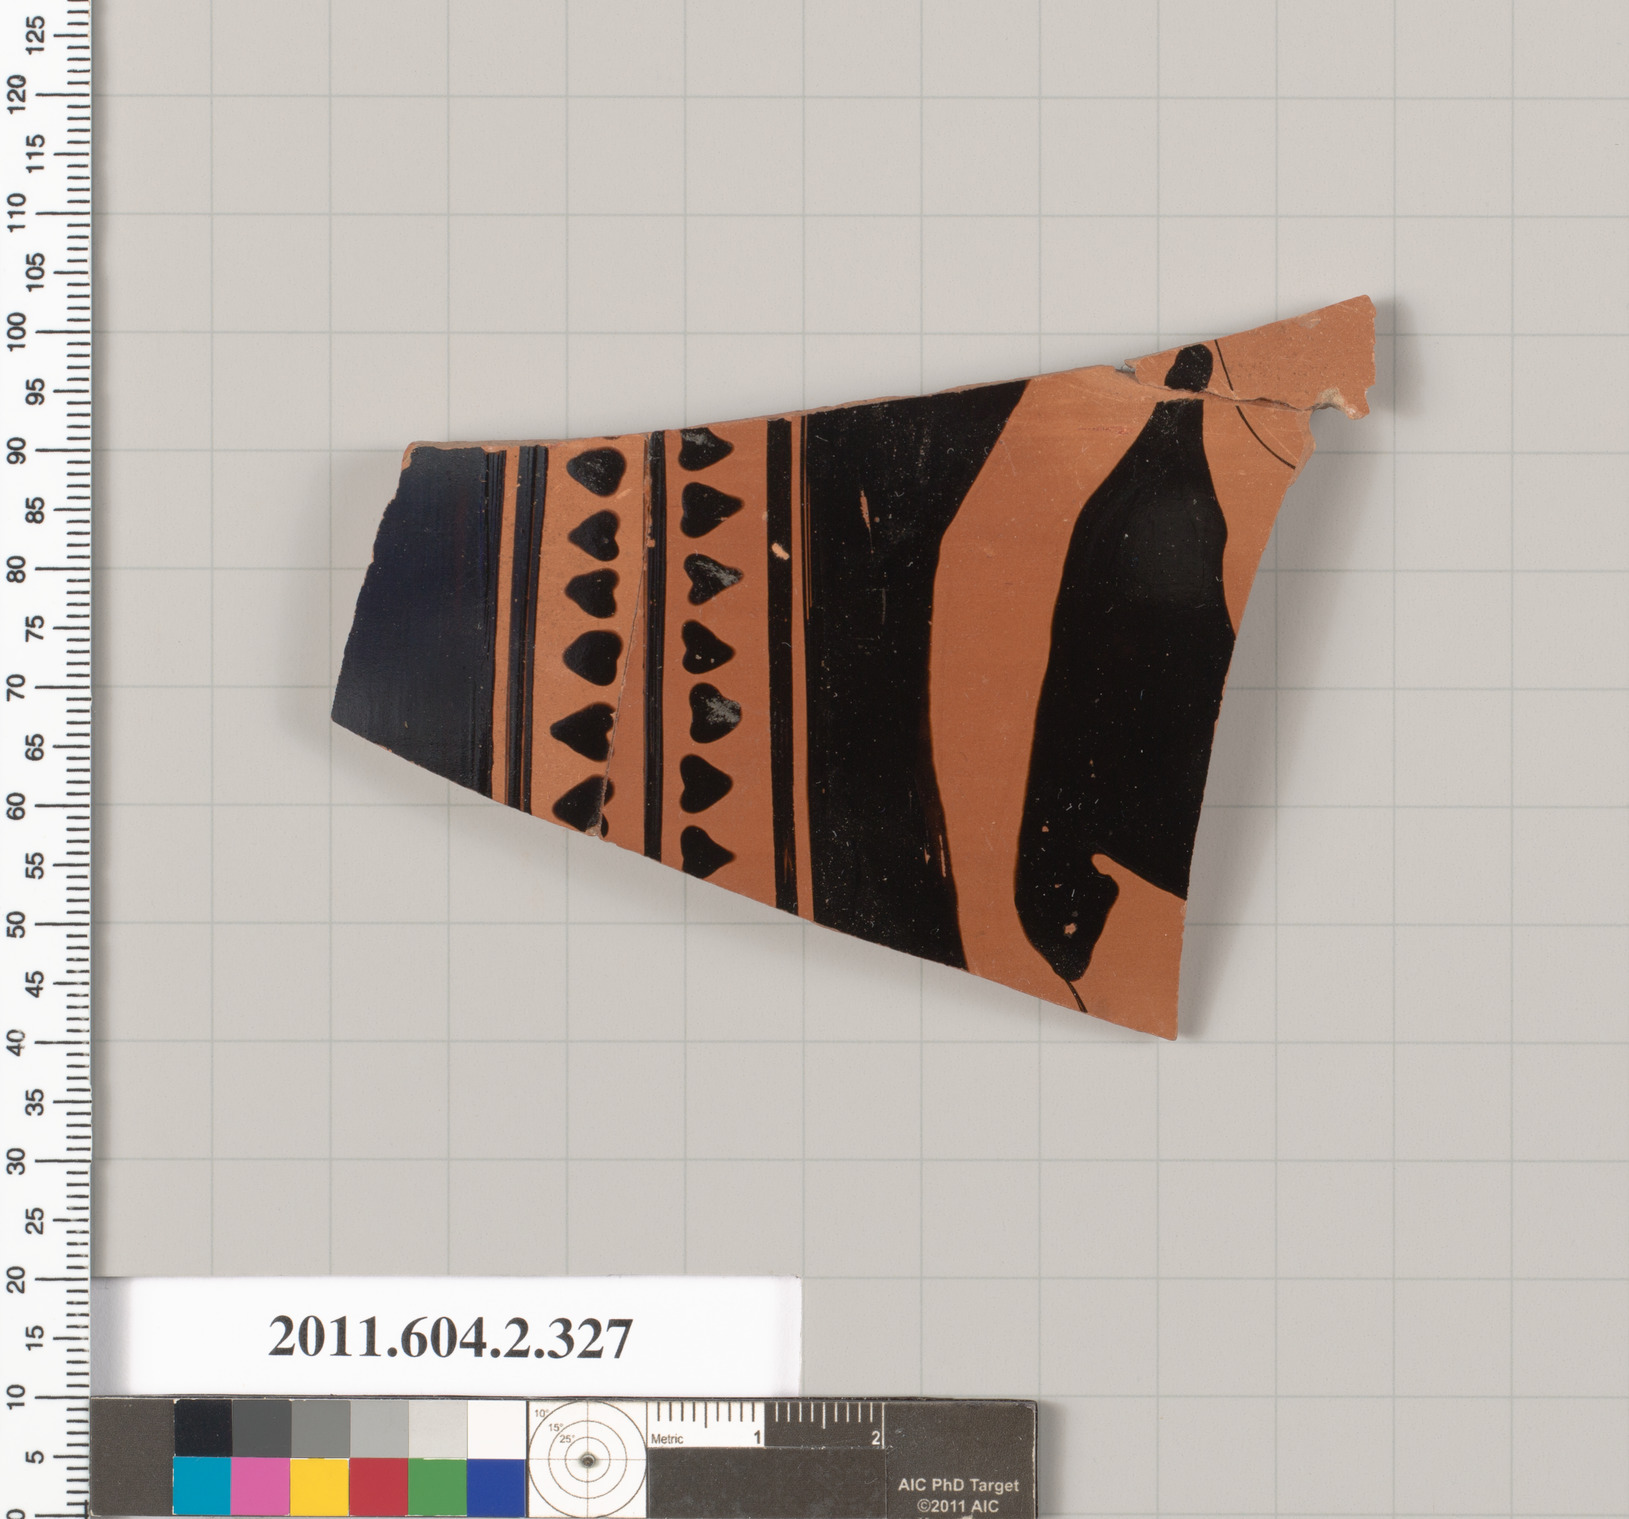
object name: column krater fragment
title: Terracotta fragment of a column-krater (bowl for mixing wine and water)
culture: greek, attic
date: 470-450 BCE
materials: terracotta